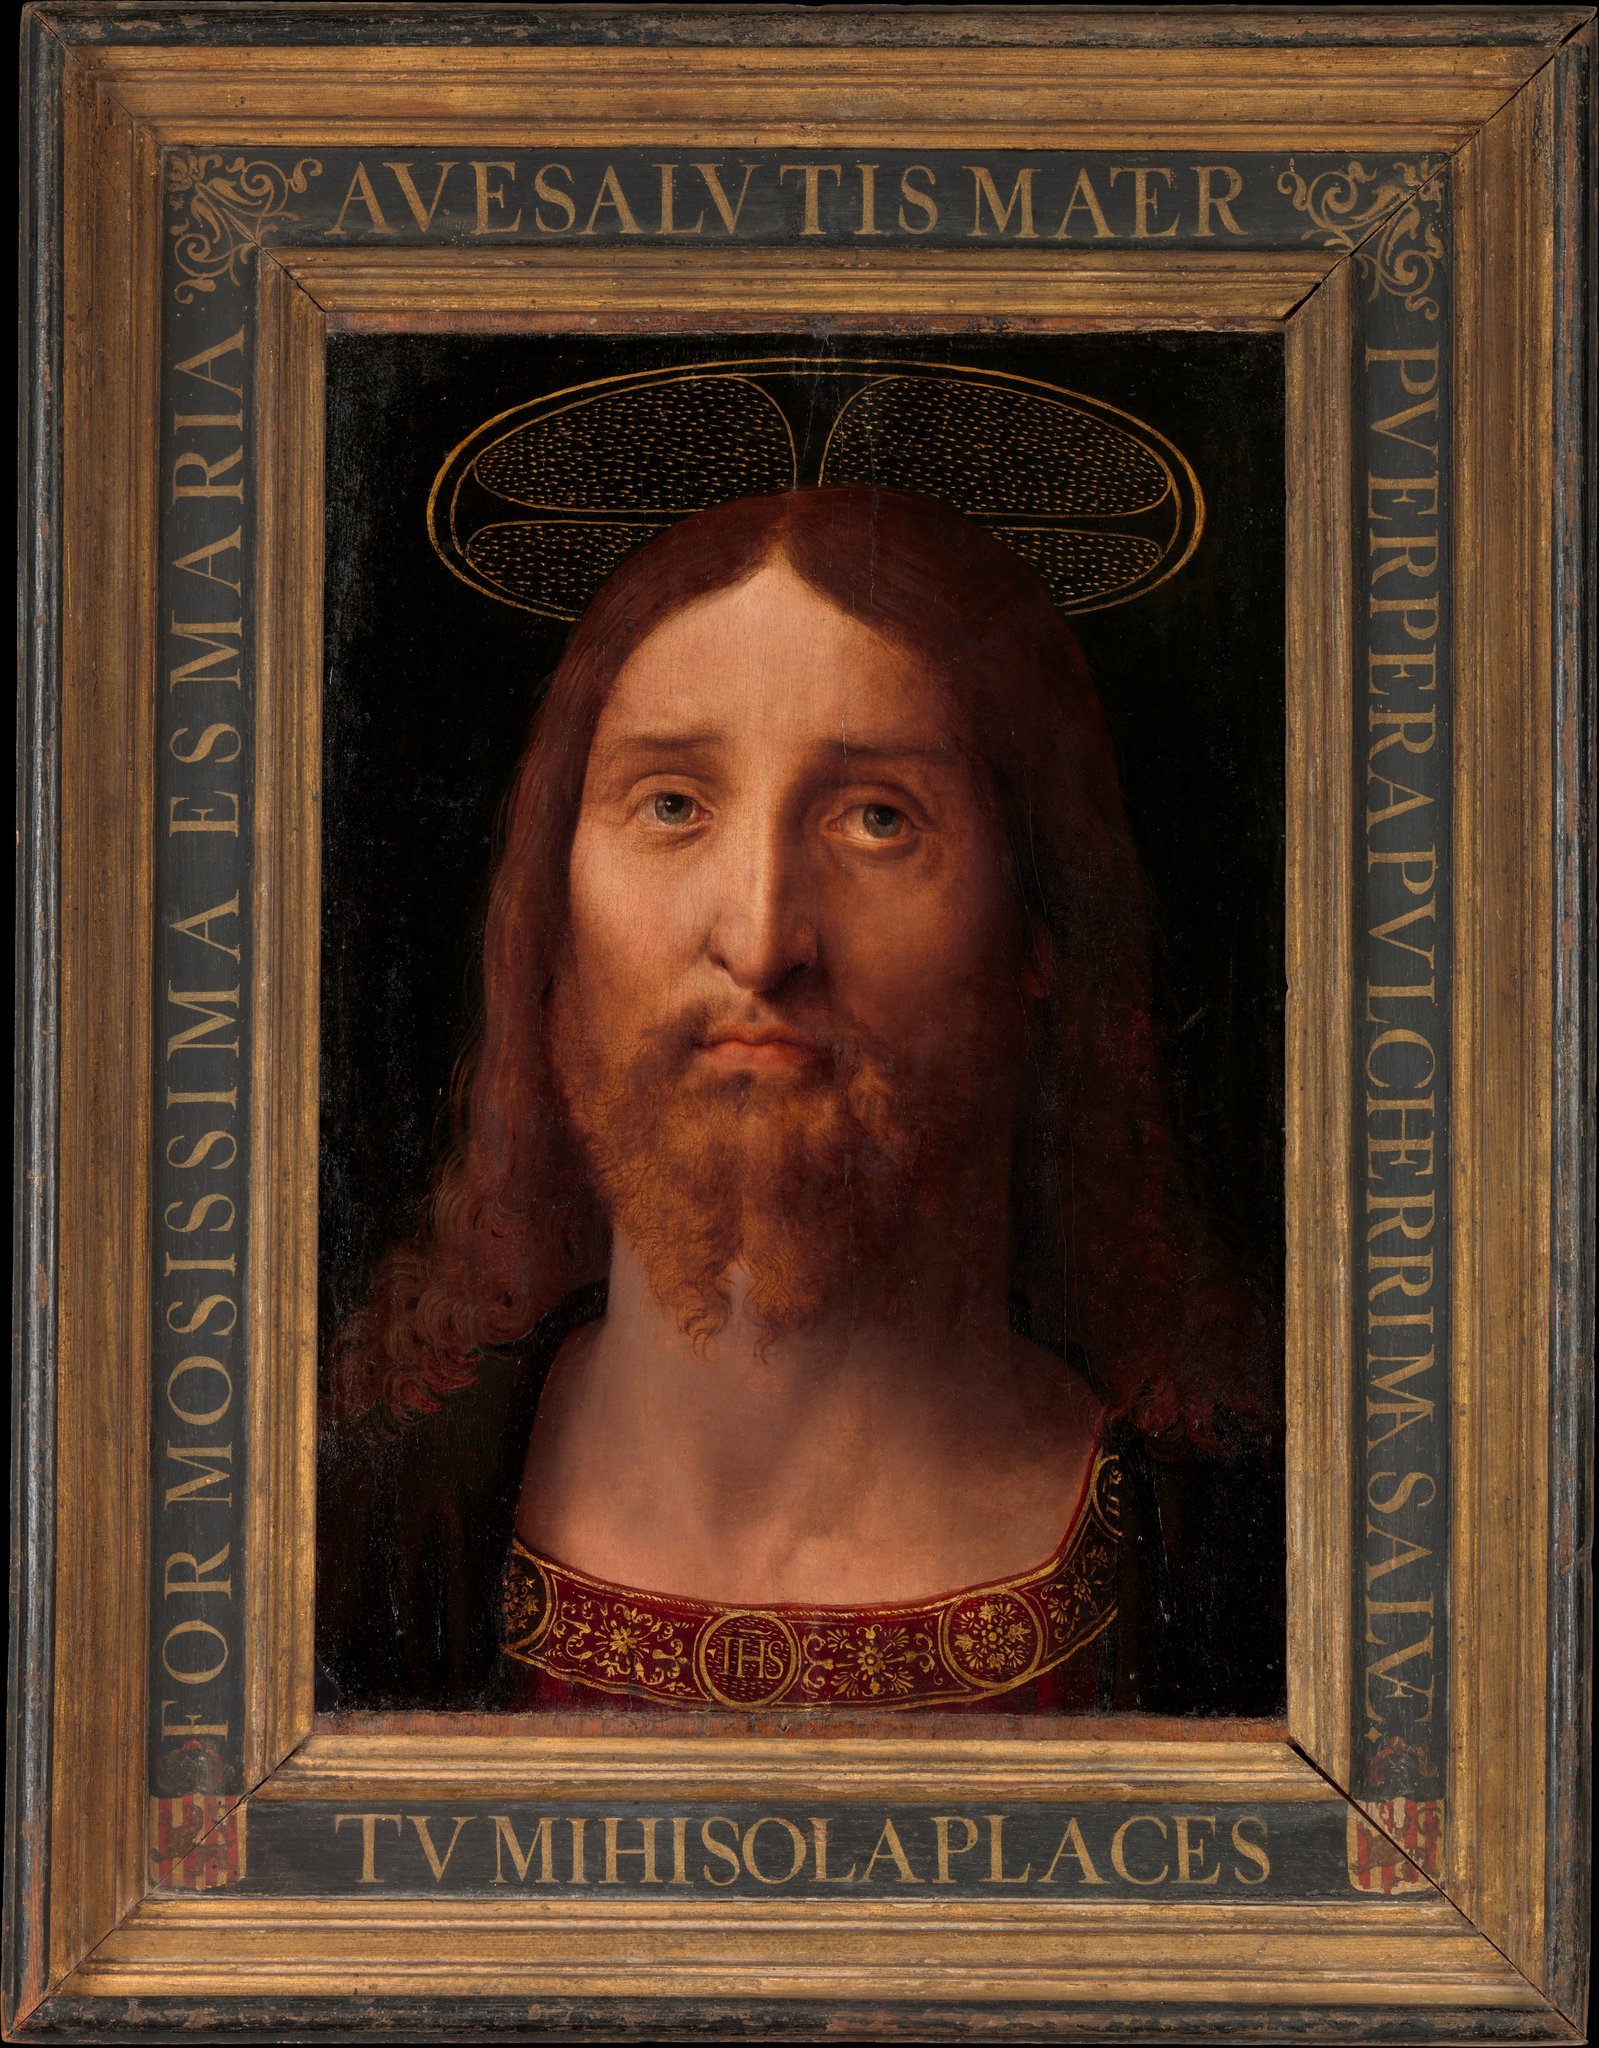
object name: painting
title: Head of Christ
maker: fernando yáñez de la almedina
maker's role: artist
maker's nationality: spanish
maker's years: 1470-1536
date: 1506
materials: oil, wood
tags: christ